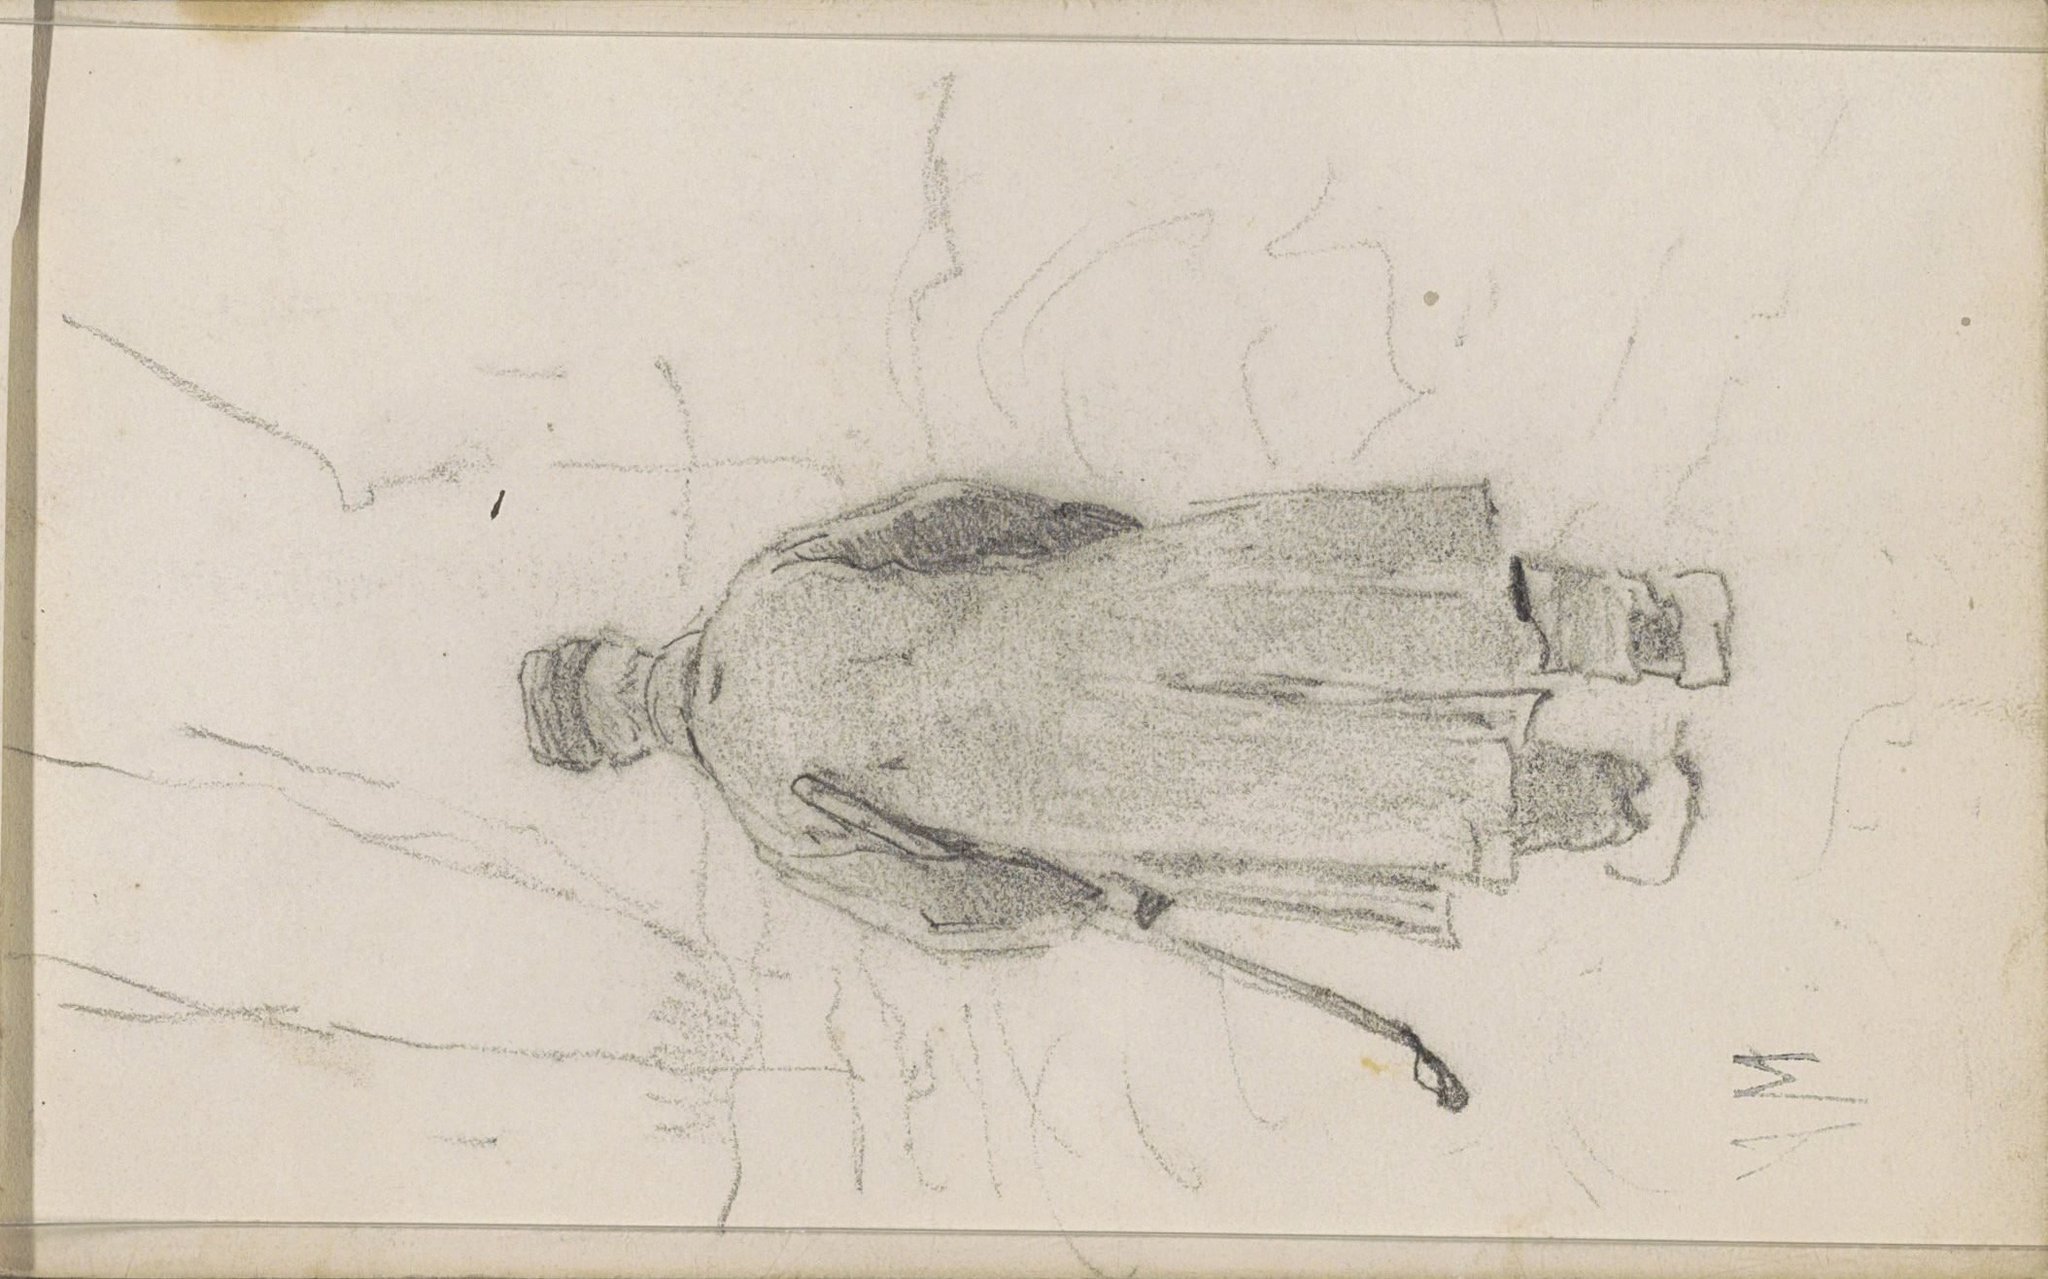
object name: sketchbook leaf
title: Herder met een stok lopend achter een schaapskudde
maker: anton mauve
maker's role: draughtsman, painter, print maker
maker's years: 1838-1888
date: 1848-1888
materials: paper, pencil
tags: herding, herdsman, herdswoman, shepherd, shepherdess, cowherd, etc., sheep, herd, flock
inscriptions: monogram: ‘AM’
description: Blad 23 recto uit een schetsboek met 44 bladen.